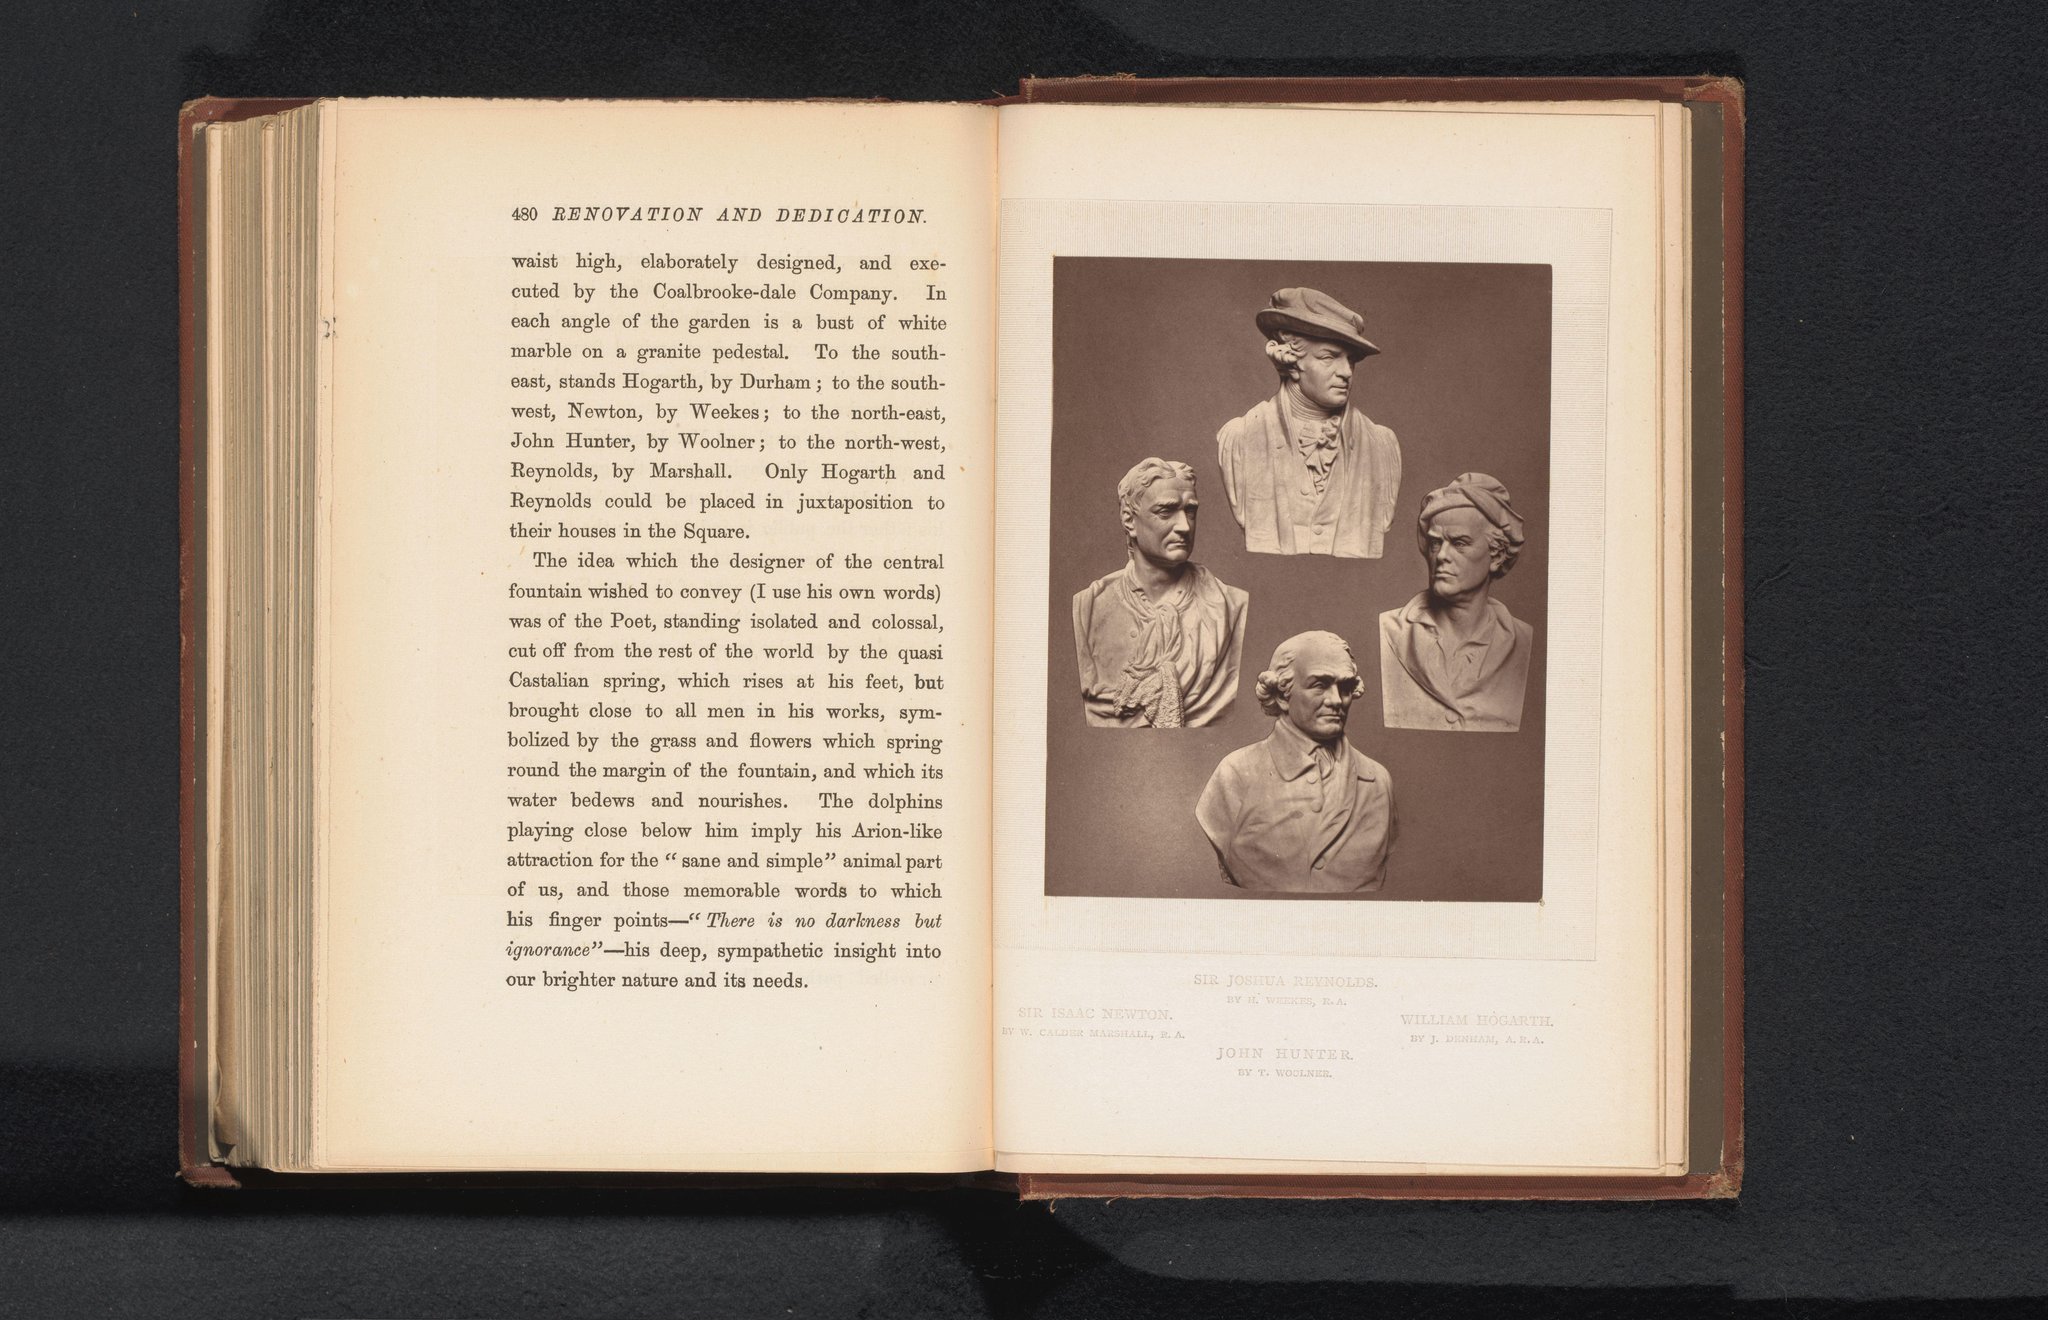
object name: photomechanical print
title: Vier bustes van Joshua Reynolds, William Hogarth, John Hunter en Isaac Newton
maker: Anonymous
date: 1869-1874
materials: paper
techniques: woodburytype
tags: print maker, draughtsman, william hogarth, painter, joshua reynolds, london, physicist, sculpture